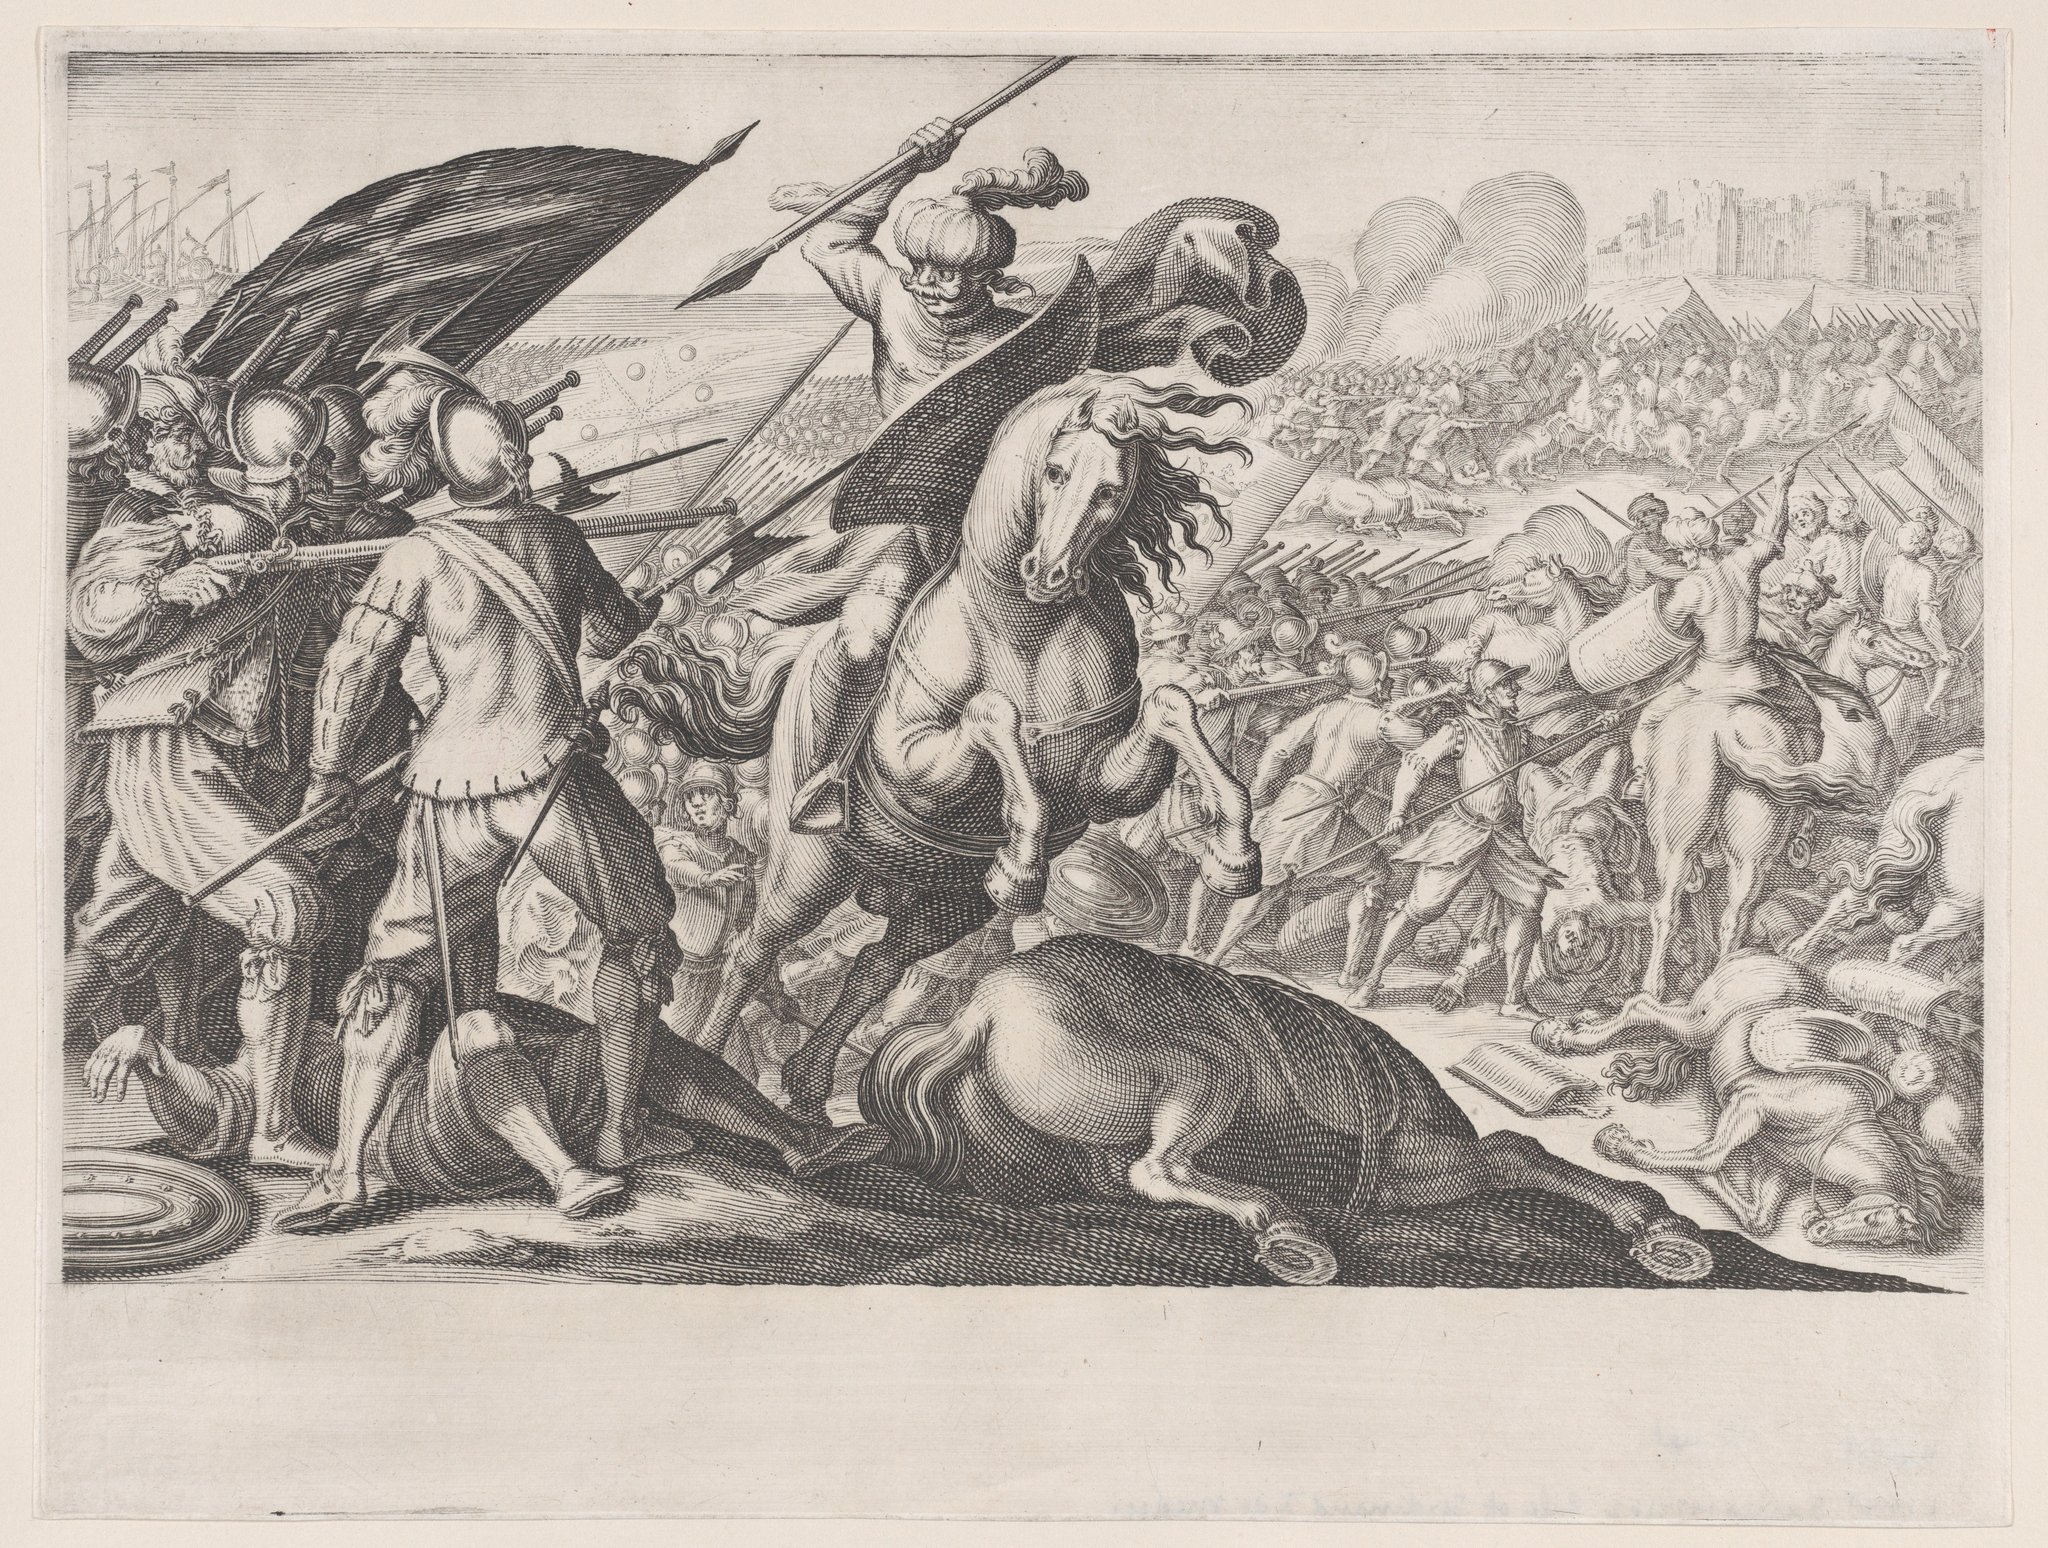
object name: print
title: Défaite de la Cavalerie Turque (Defeat of the Turkish Cavalry), from La Vie de Ferdinand Ier de Médicis série appelée aussi Les Batailles des Médicis (The Life of Ferdinand I de'Medici also called The Medici Battles)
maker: jacques callot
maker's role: artist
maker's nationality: french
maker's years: 1592-1635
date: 1614-1620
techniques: engraving